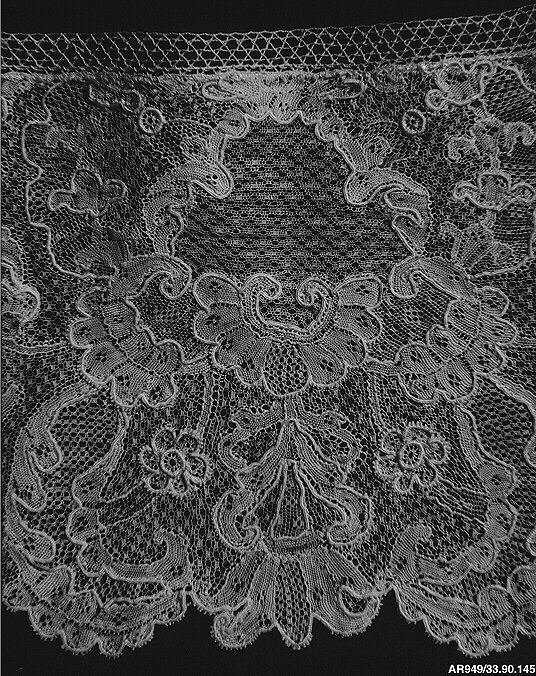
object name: edging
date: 1701-1733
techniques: lace